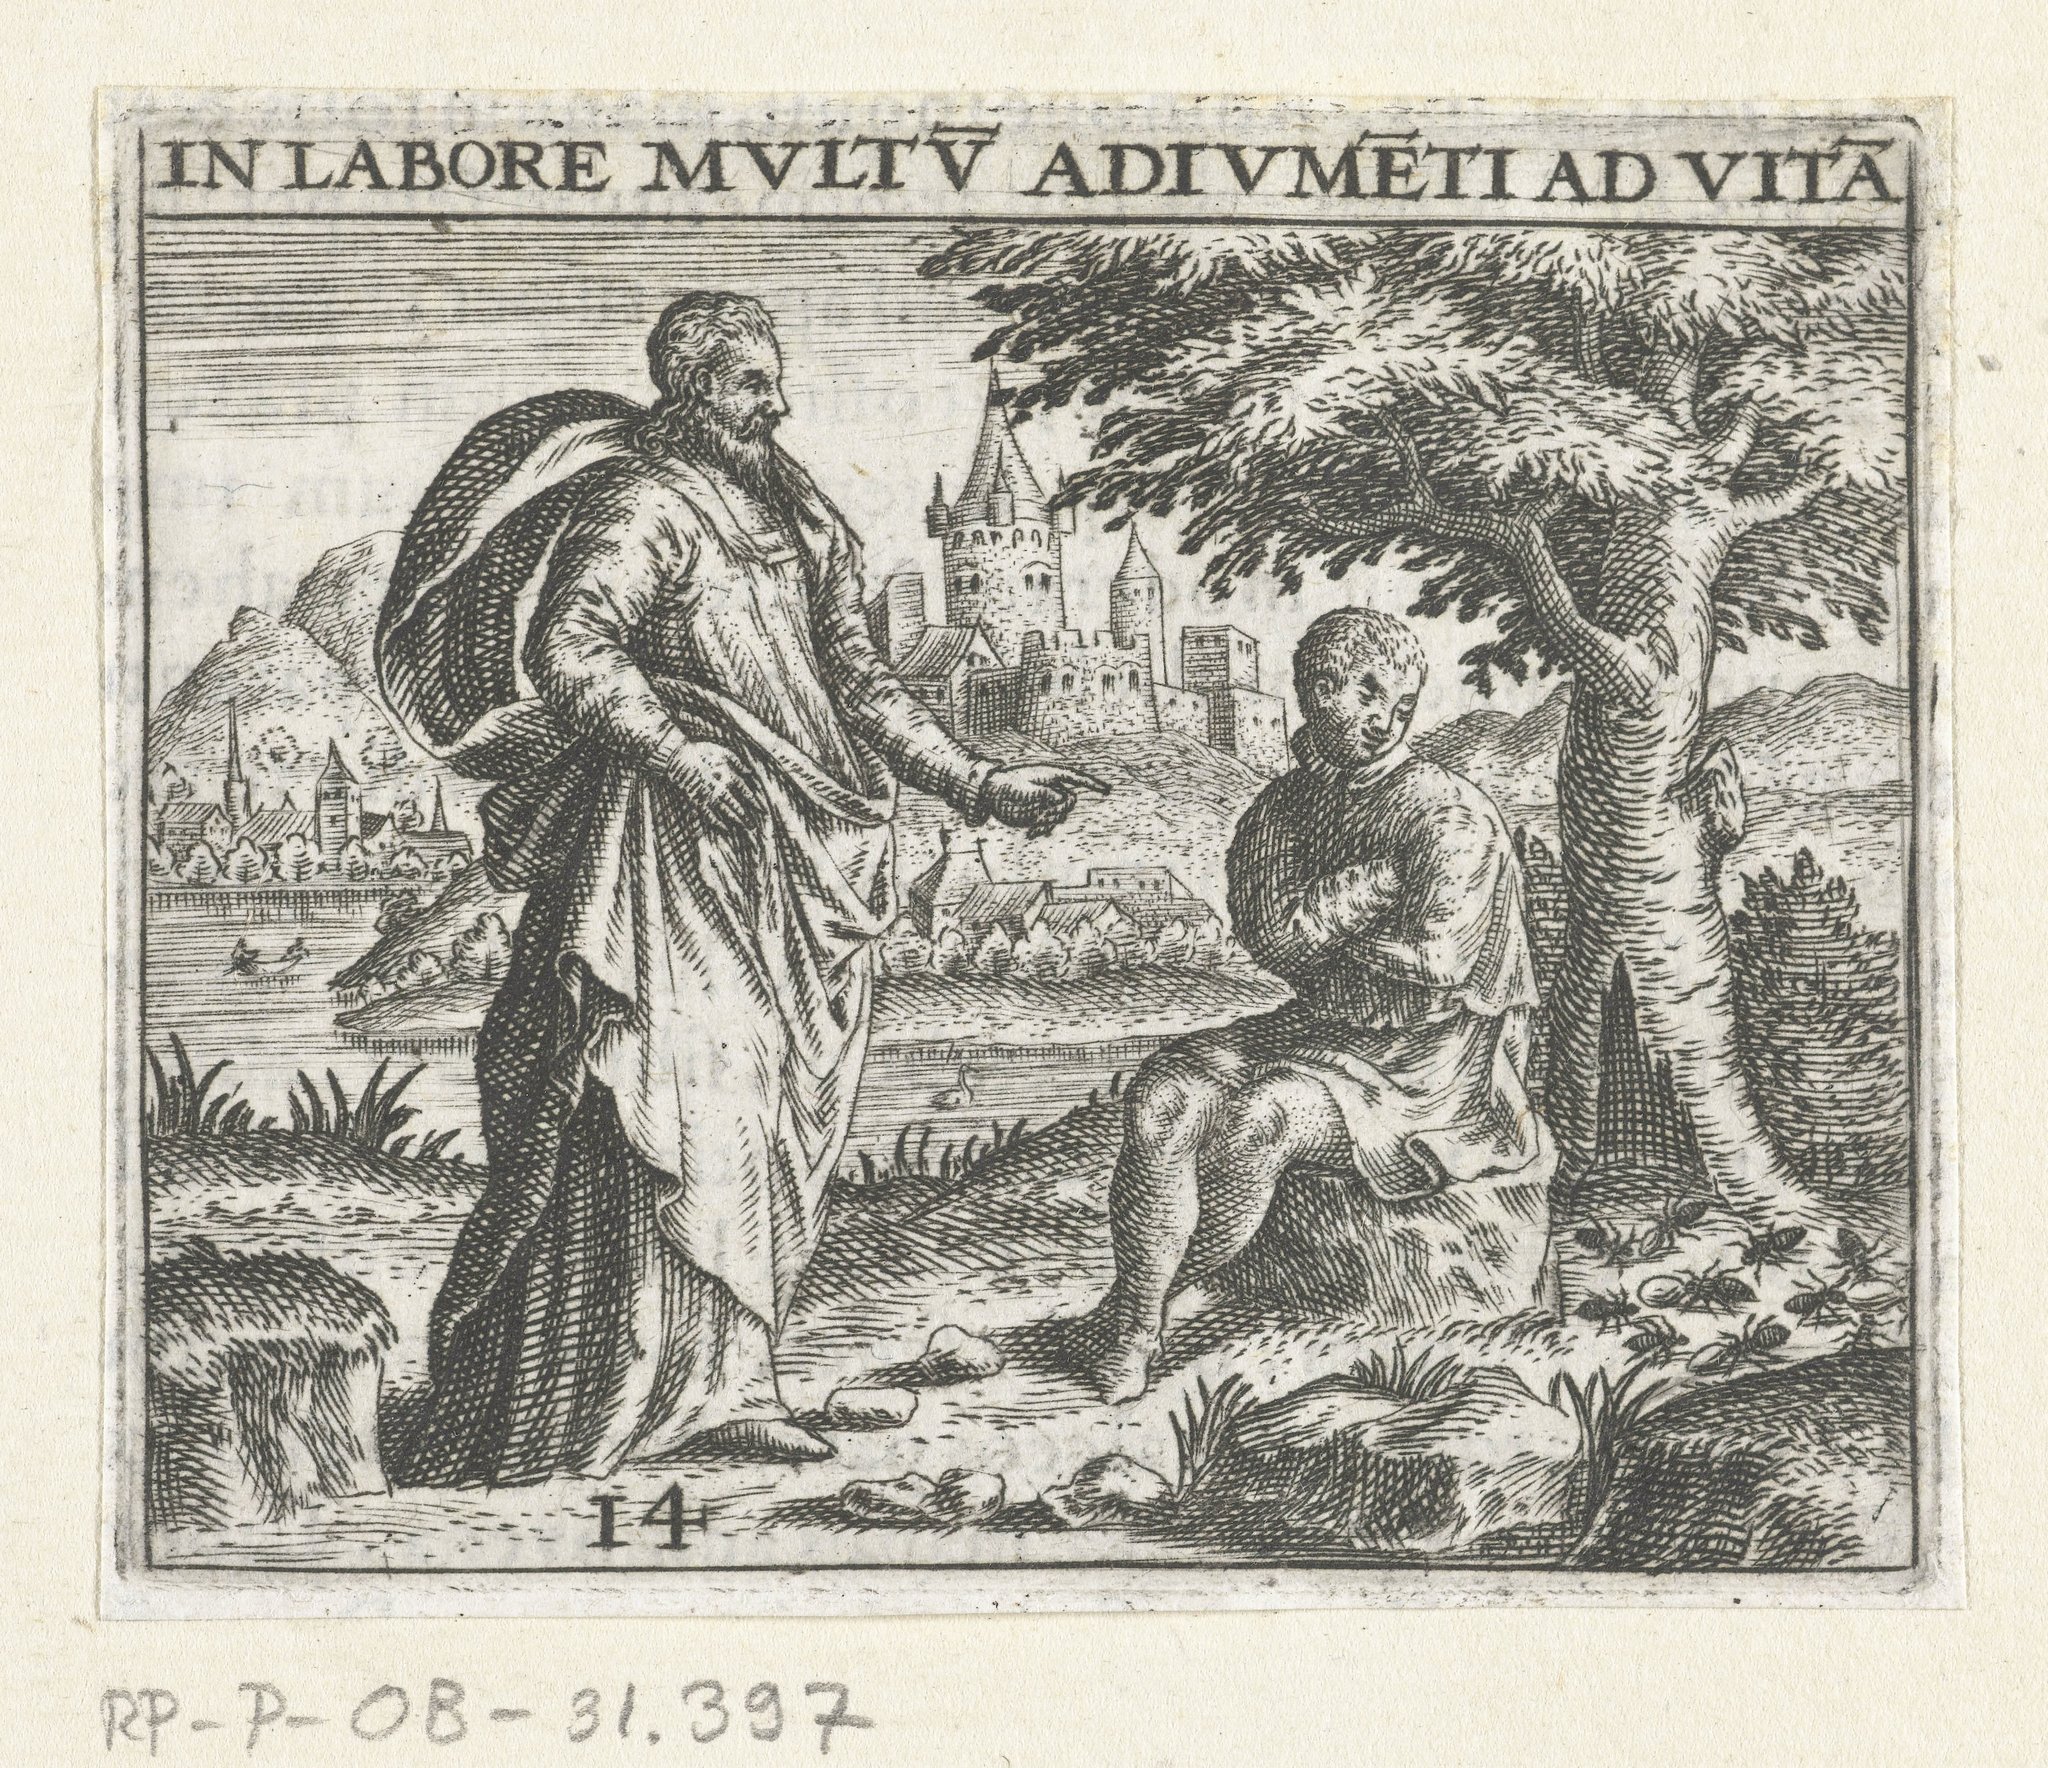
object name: cognizance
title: IN LABORE MVLTV ADIVMETI AD VITA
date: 1596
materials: paper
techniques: engraving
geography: frankfurt am main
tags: person with a physical disability, plants; vegetation (+ stem, trunk), insects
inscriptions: collector's mark: Lugt 240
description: Een man zit met armen en benen over elkaar zit op een steen bij een rivier. Een staande man in toga spreekt hem toe. Achter de zittende man staat een holle boom en uit de stam komen insecten.